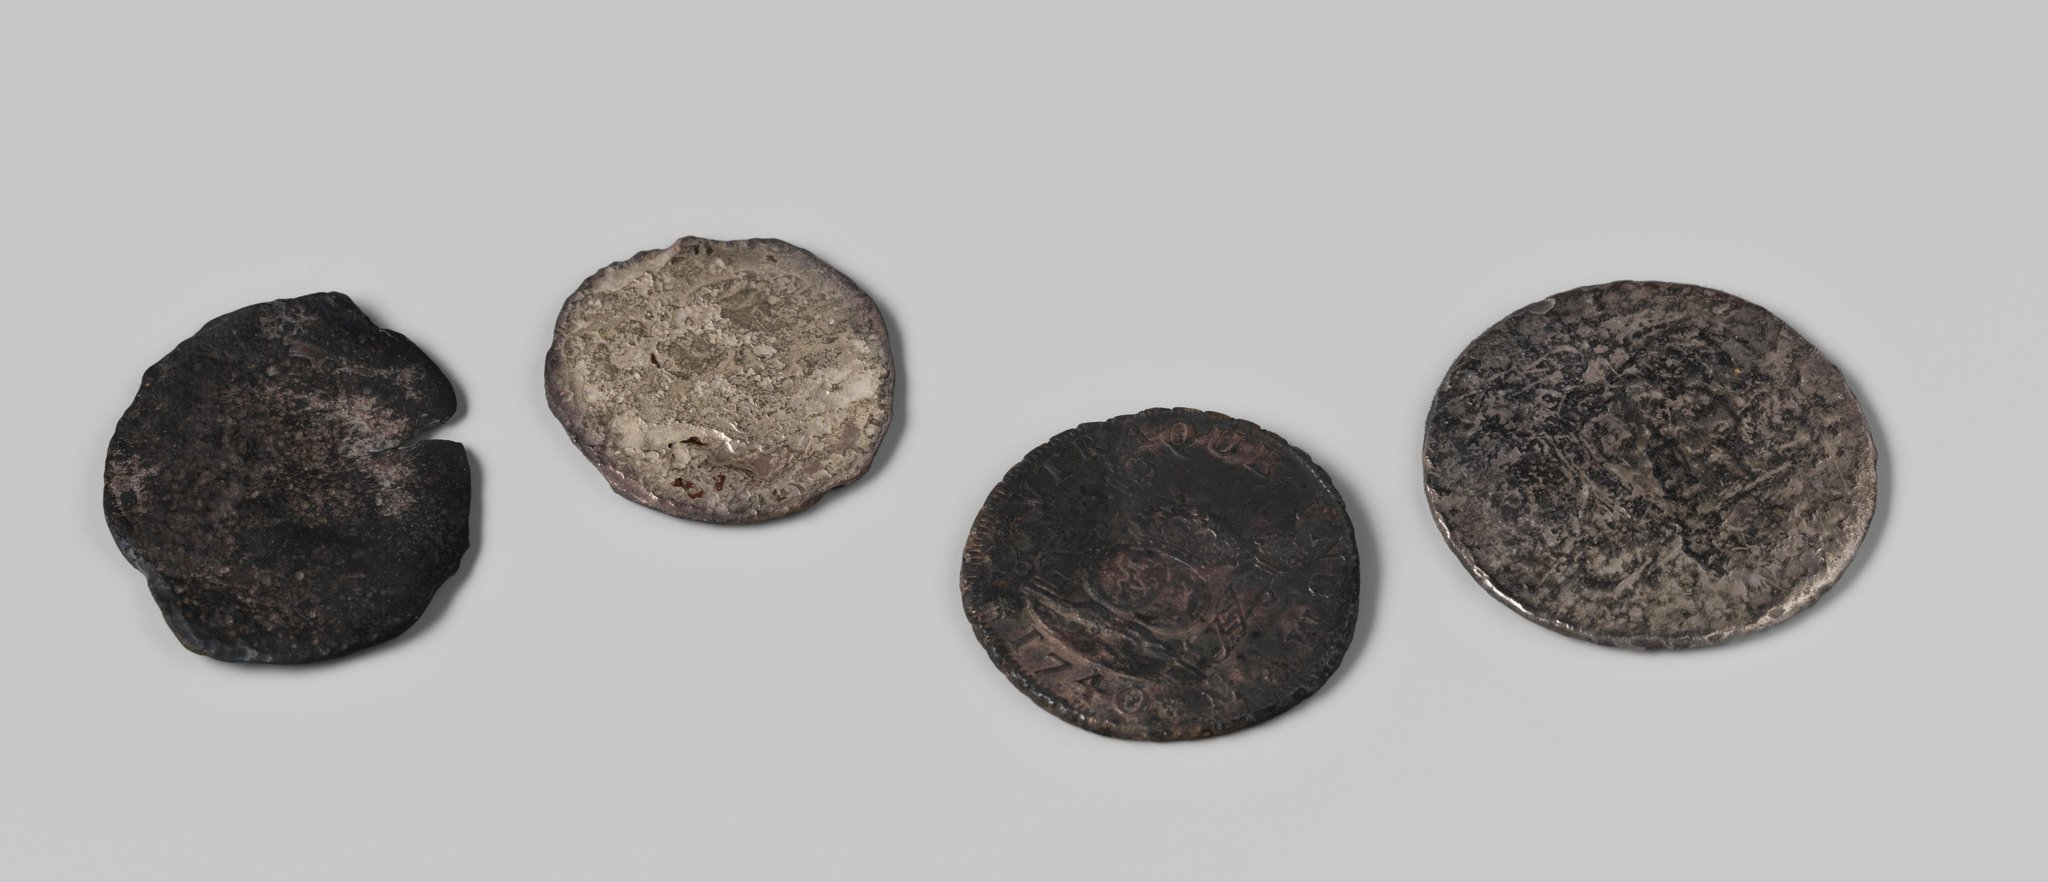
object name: coin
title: Munten uit het wrak van de Oostindiëvaarder Hollandia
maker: Anonymous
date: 1700-1743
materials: silver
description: Vier munten, waaronder één acht reaal (type met de pilaren van Hercules), één vier reaal (Mexico 1740), één vier reaal (ondetermineerbaar, type met de pilaren) en een ondetermineerbare acht reaal (type cob).